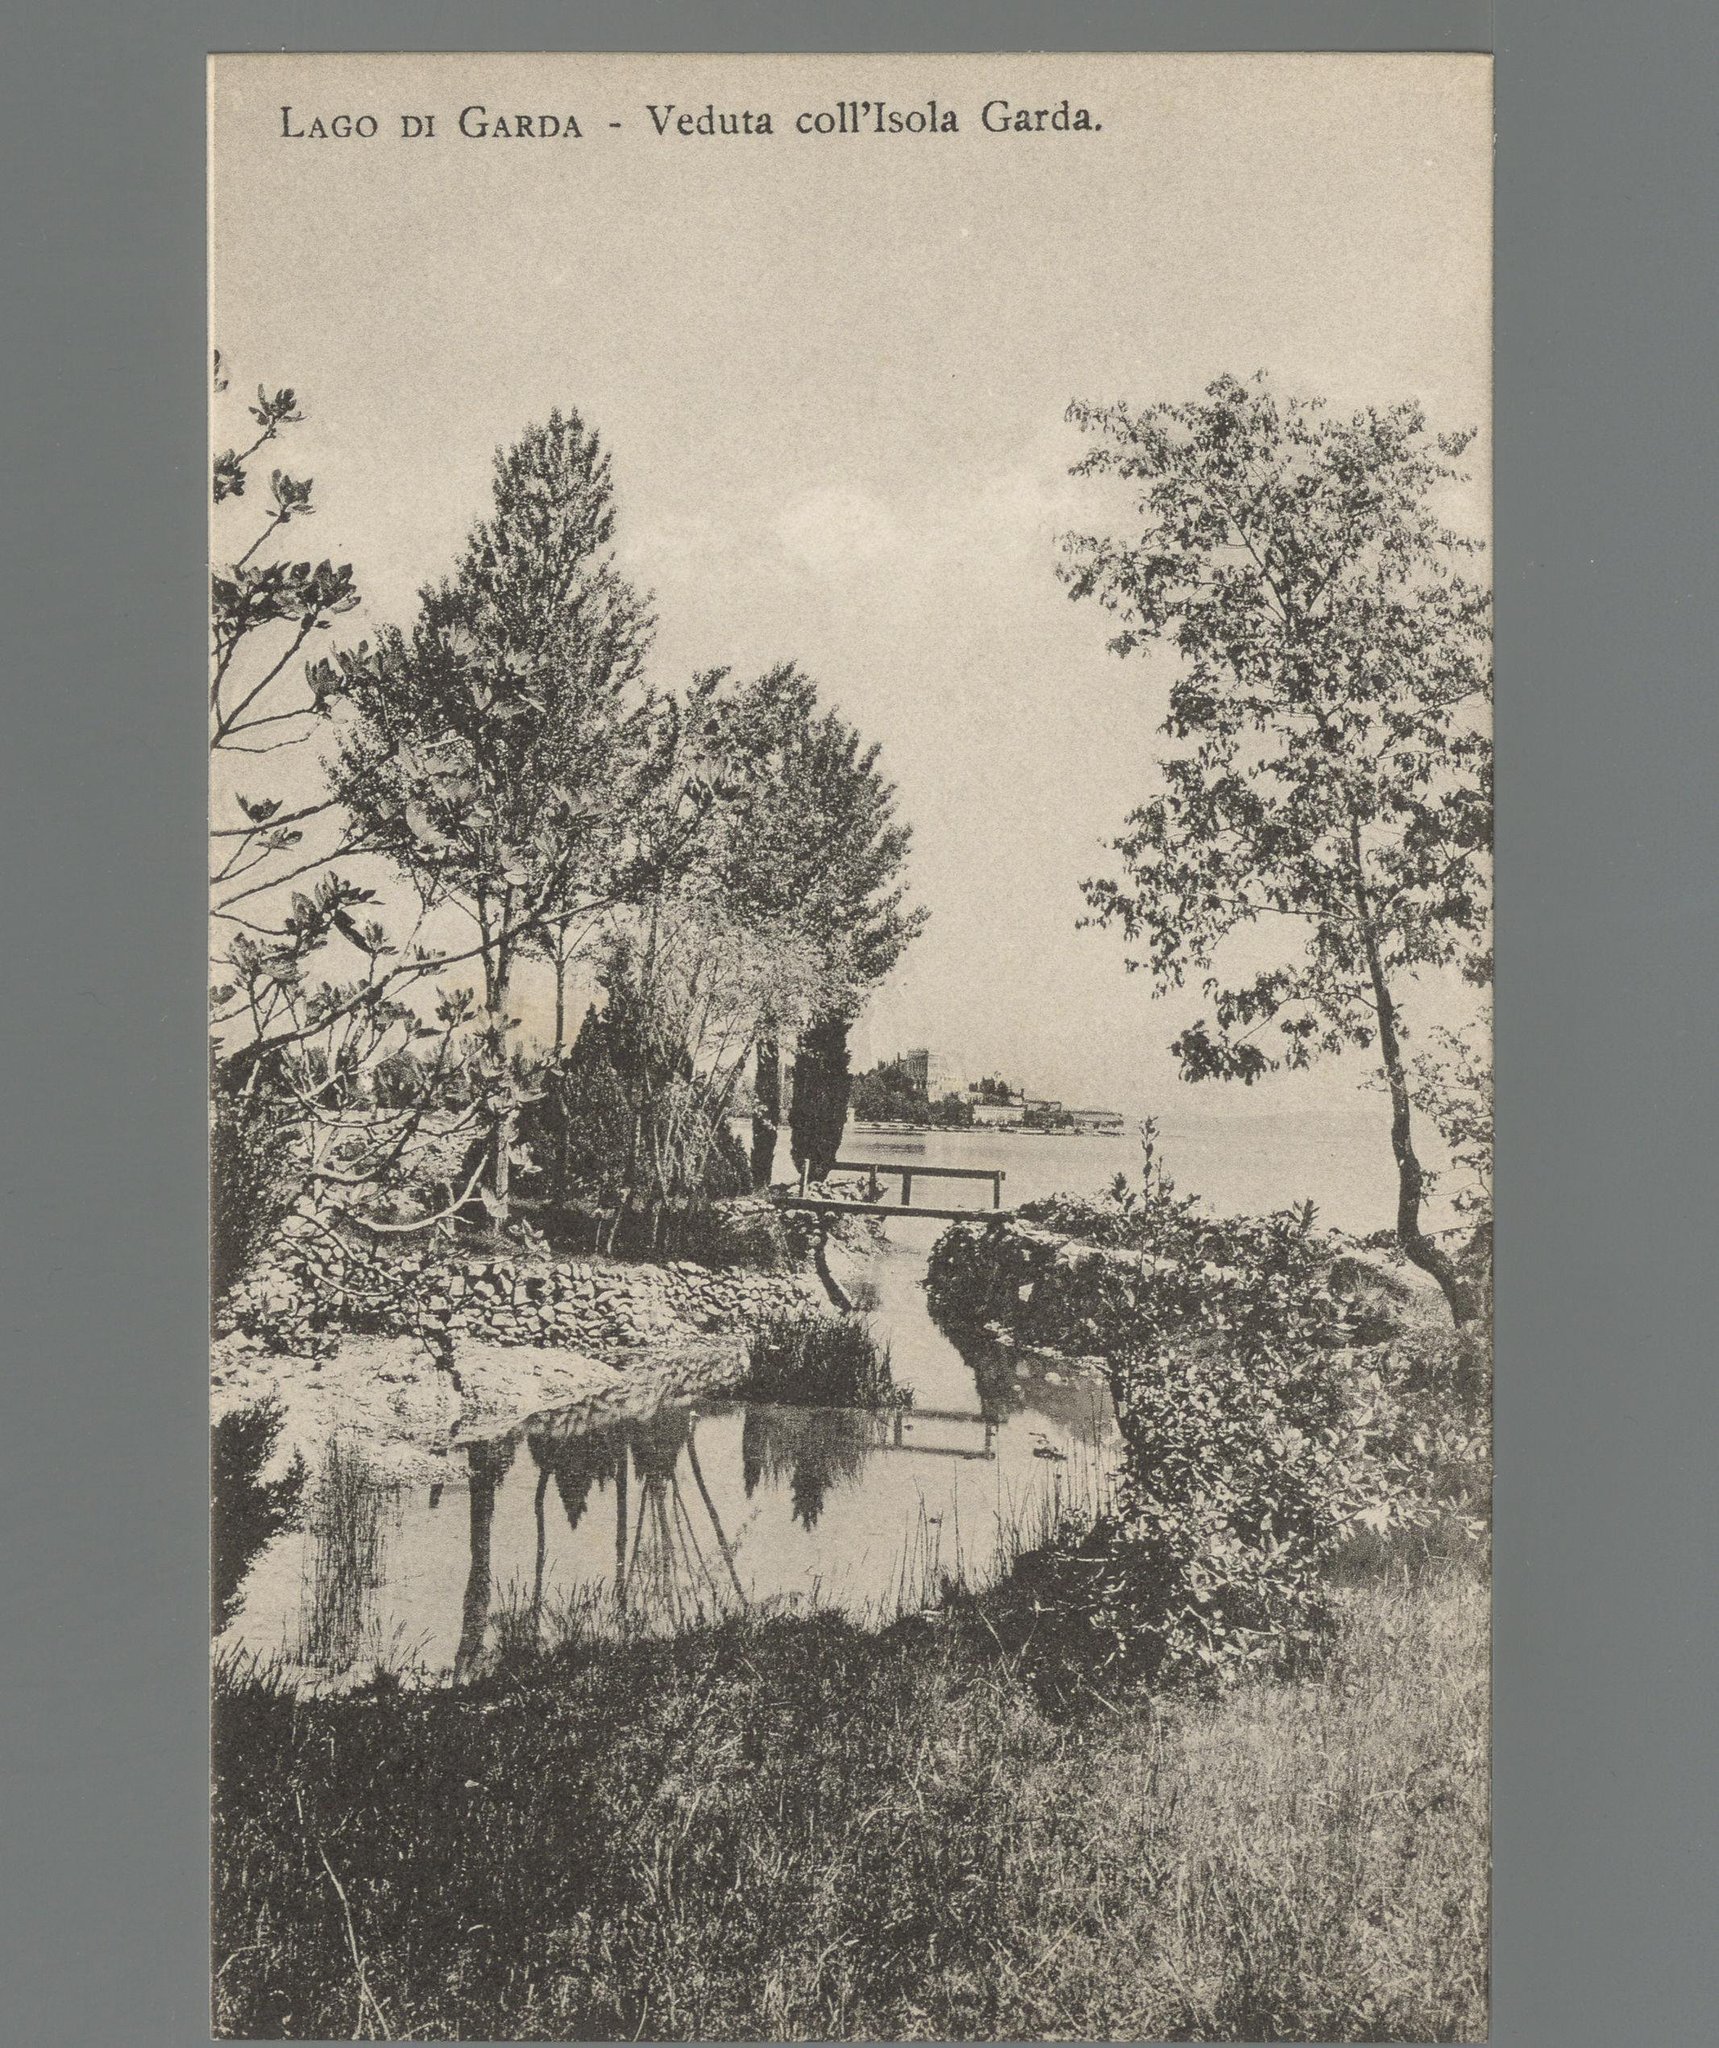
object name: ansichtkaart, prentbriefkaart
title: Lago di Garda. Veduta coll'Isola Garda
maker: Anonymous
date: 1906-1930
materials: cardboard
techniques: photograph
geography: lake garda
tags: landscapes with waters, waterscapes, seascapes (in the temperate zone), lake